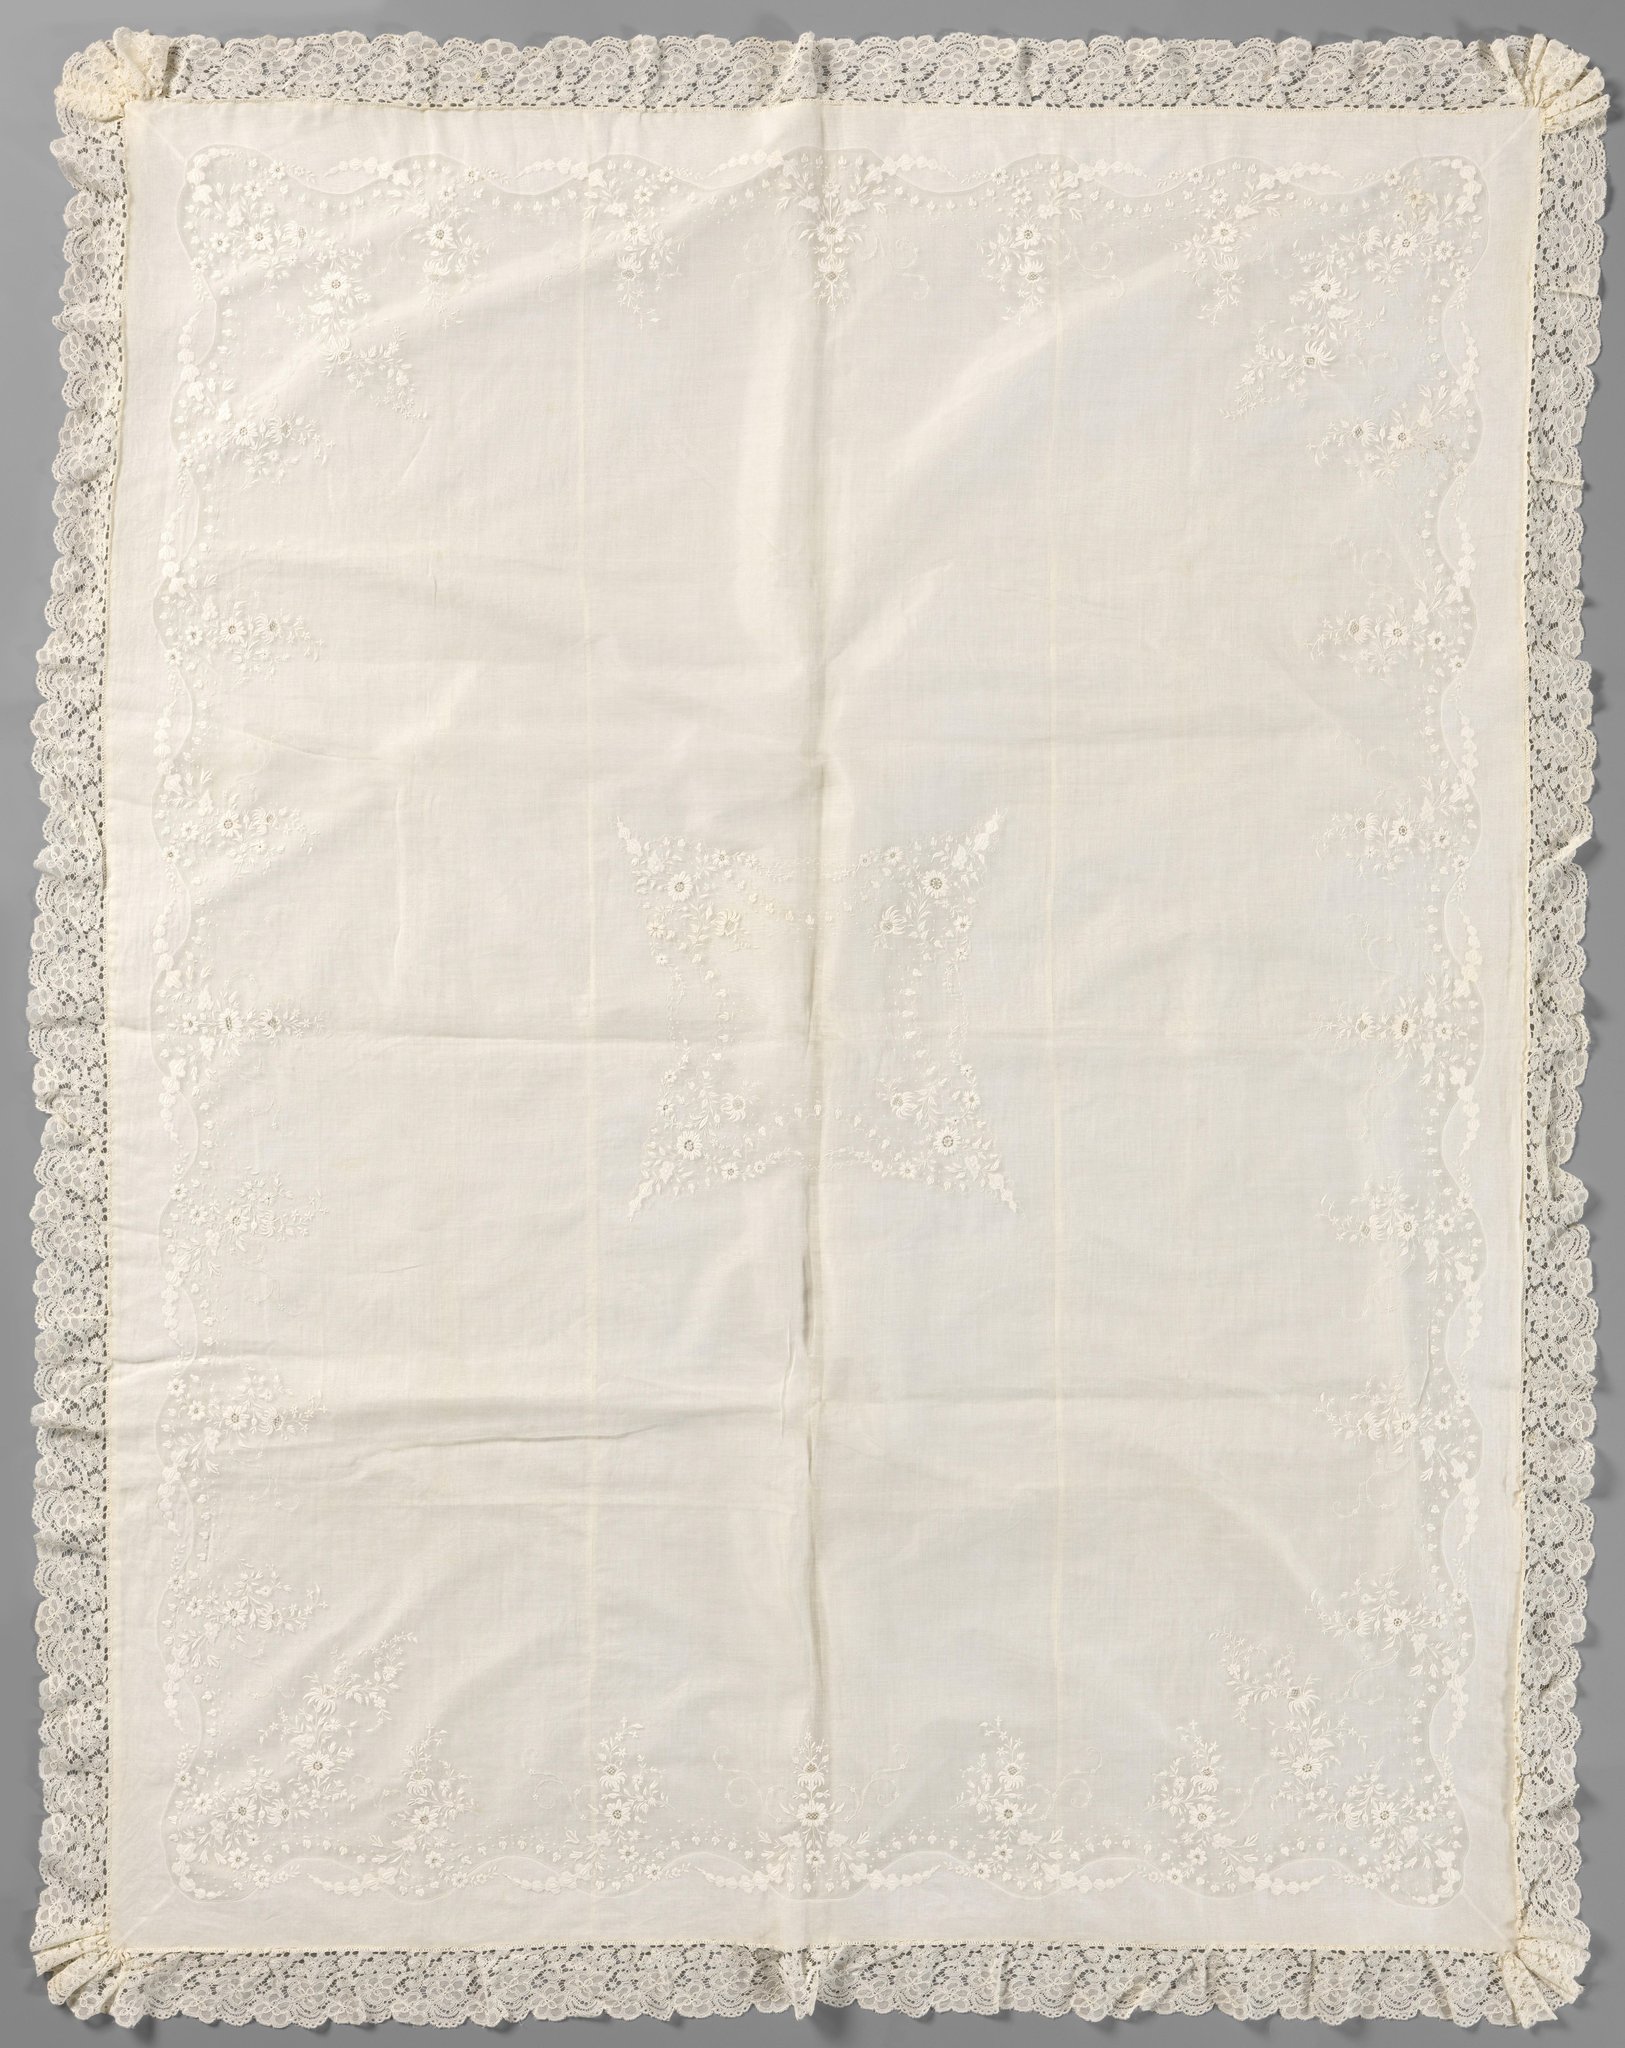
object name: doopkleed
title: Doopkleed van batist met plumetis borduurwerk en een rand machinale kant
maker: Anonymous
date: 1830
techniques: embroidered, lace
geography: netherlands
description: Doopkleed van batist met borduurwerk en een rand van naturelkleurige machinale kant. Het kleed is rechthoekig en heeft een naar de binnenzijde golvende, open zoom in het batist. Het kantpatroon heeft in de schulpen neerhangende rozen. Het borduurwerk heeft een patroon van een ruitvormig midden en een rand van bloemtakken, verbonden door een slinger waarvan de golven tegengesteld en over de zoomgolven lopen. Langs de zoomgolven staan losse bladeren en rijen moesjes. Achter het batist is een cremekleurige voering gezet.